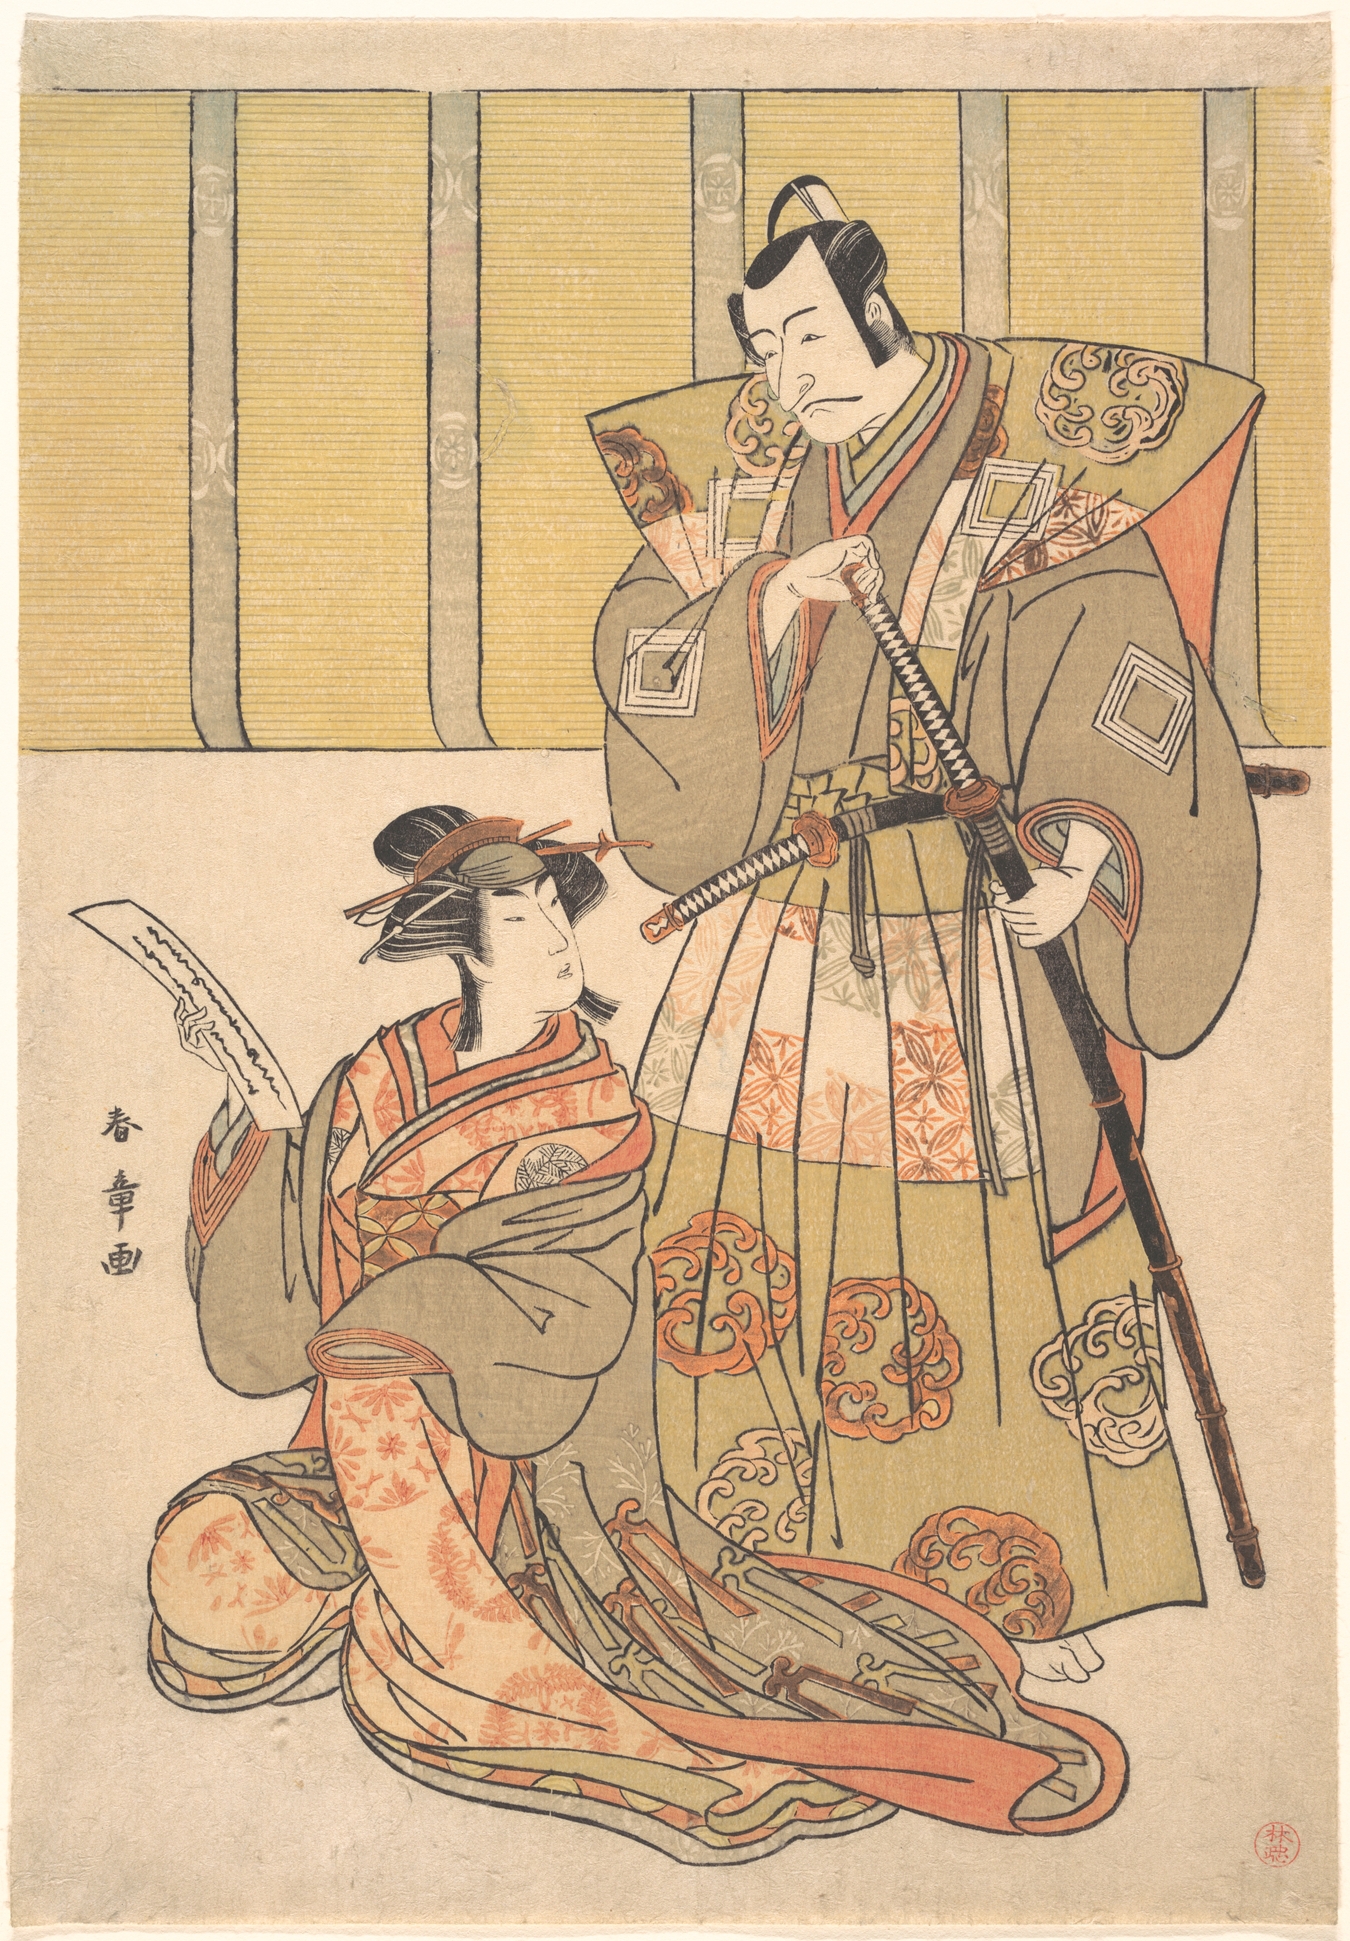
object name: woodblock print nishiki e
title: Ichikawa Danjūrō V as Kūdo no Suketsune, and Nakamura Rikō as Oiso no Tora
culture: japanese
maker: katsukawa shunshō 勝川春章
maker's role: artist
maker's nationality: japanese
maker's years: 1726-1792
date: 1701-1800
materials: ink, paper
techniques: nishiki e, woodblock print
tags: swords,actors